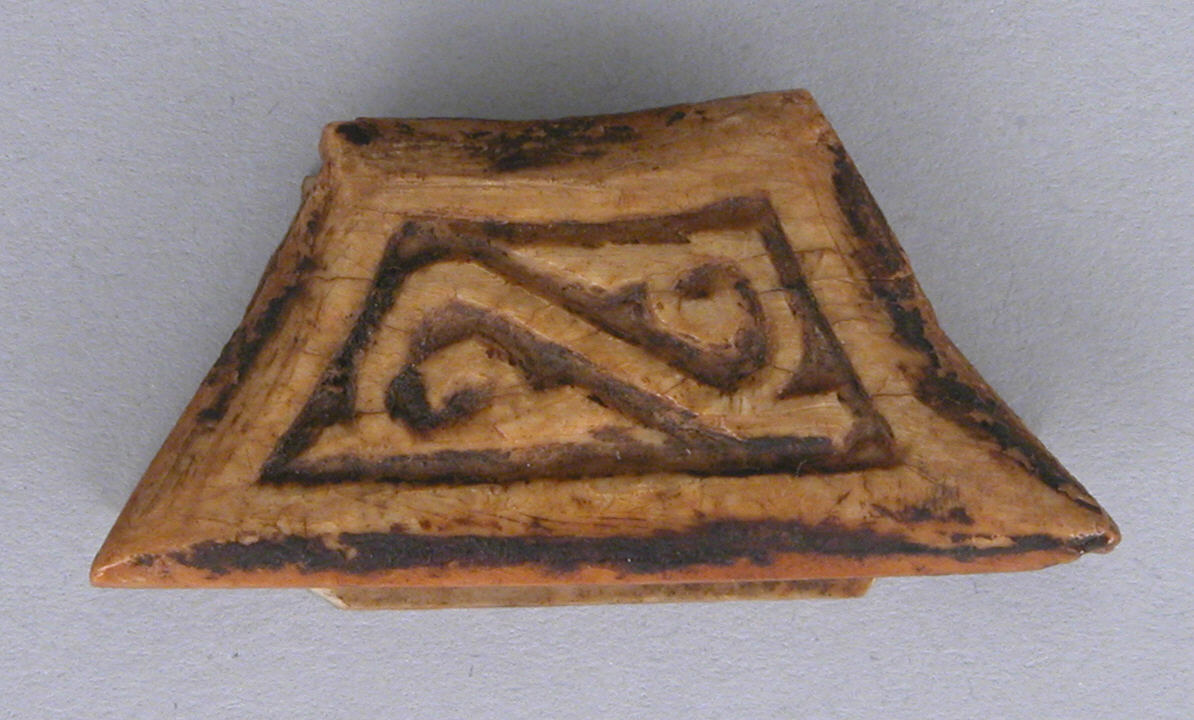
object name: panel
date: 1301-1500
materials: wood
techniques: carving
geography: egypt